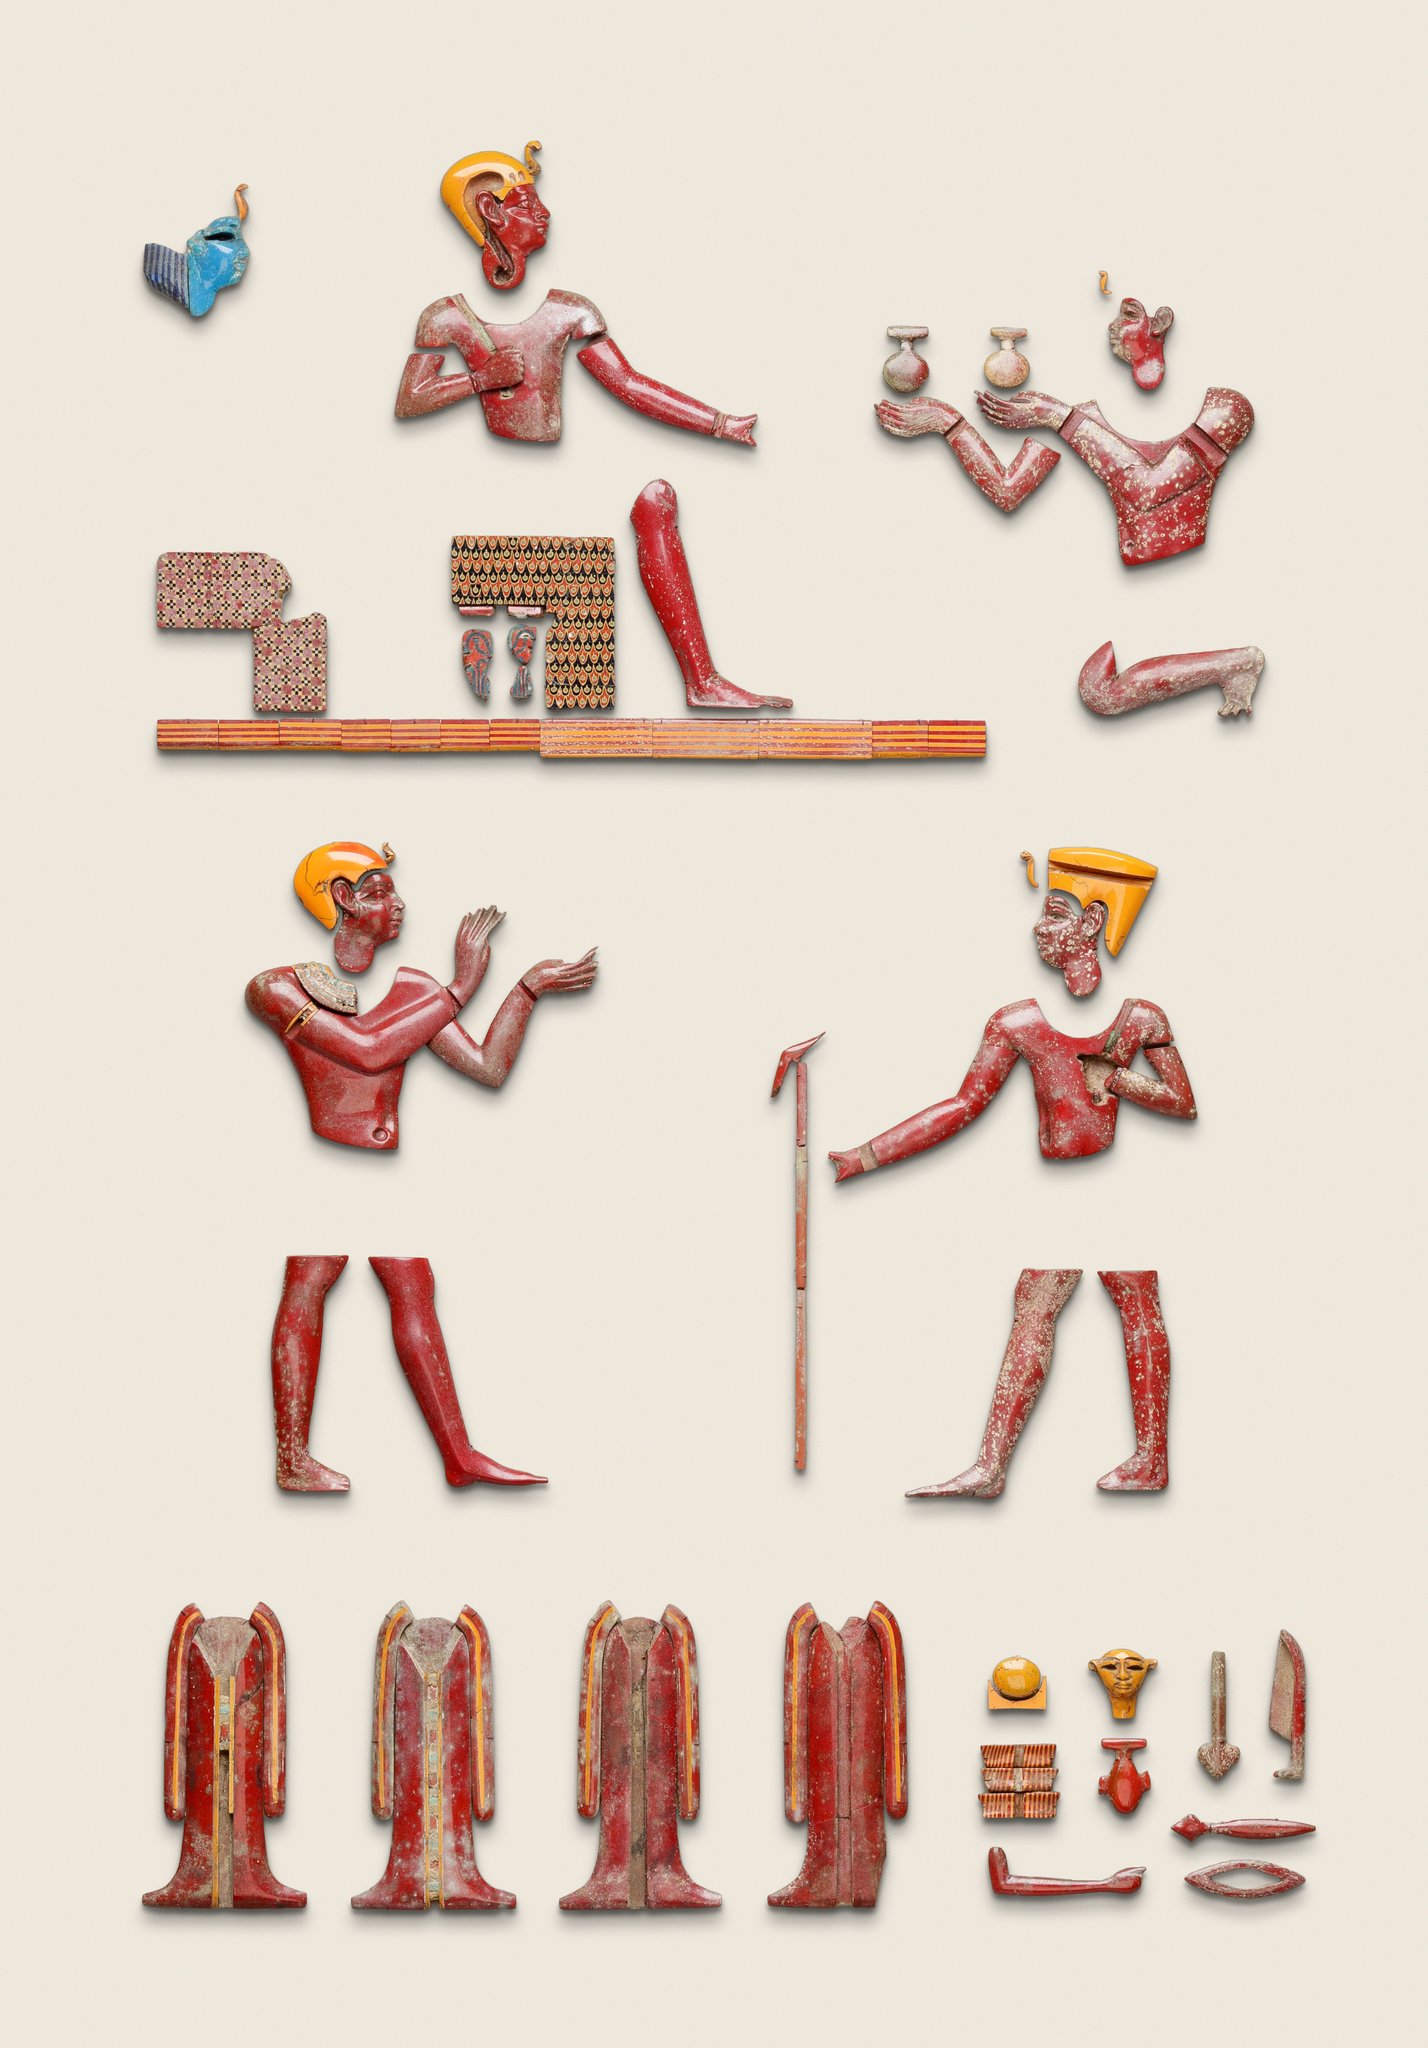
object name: inlay, shrine element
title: Inlays and Shrine Elements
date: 380-330 BCE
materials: metal, glass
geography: egypt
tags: men